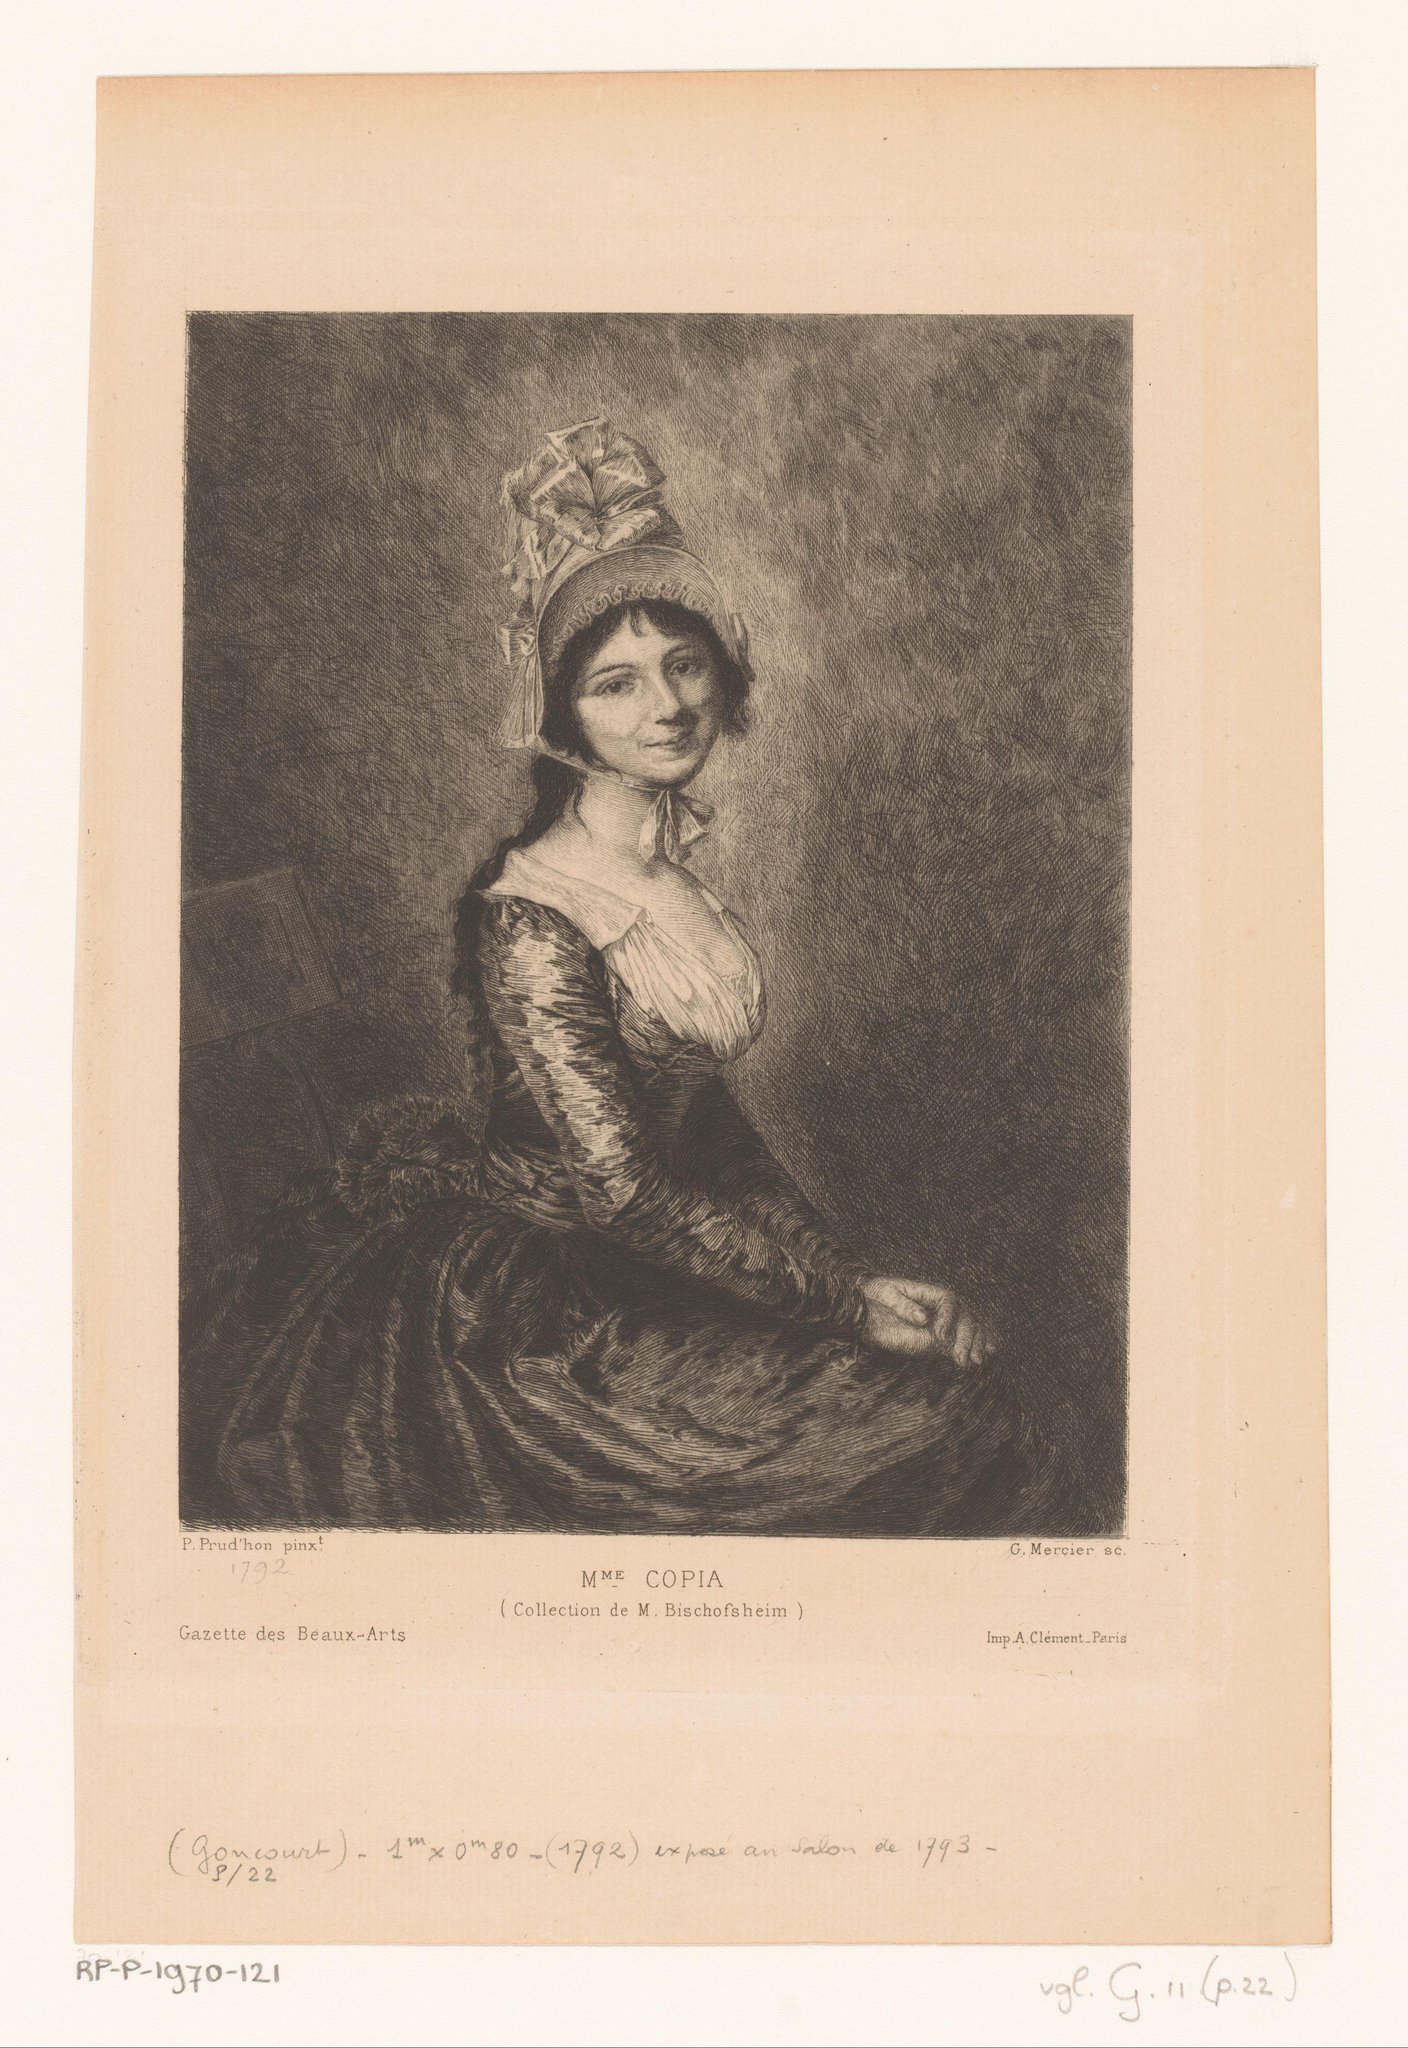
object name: print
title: Portret van Madame Copia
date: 1792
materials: paper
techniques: etching, intaglio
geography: paris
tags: historical persons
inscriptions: collector's mark: Lugt 2760, collector's mark: Lugt 2228a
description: Prent uit: Gazette des Beaux-Arts, uitgave onbekend.